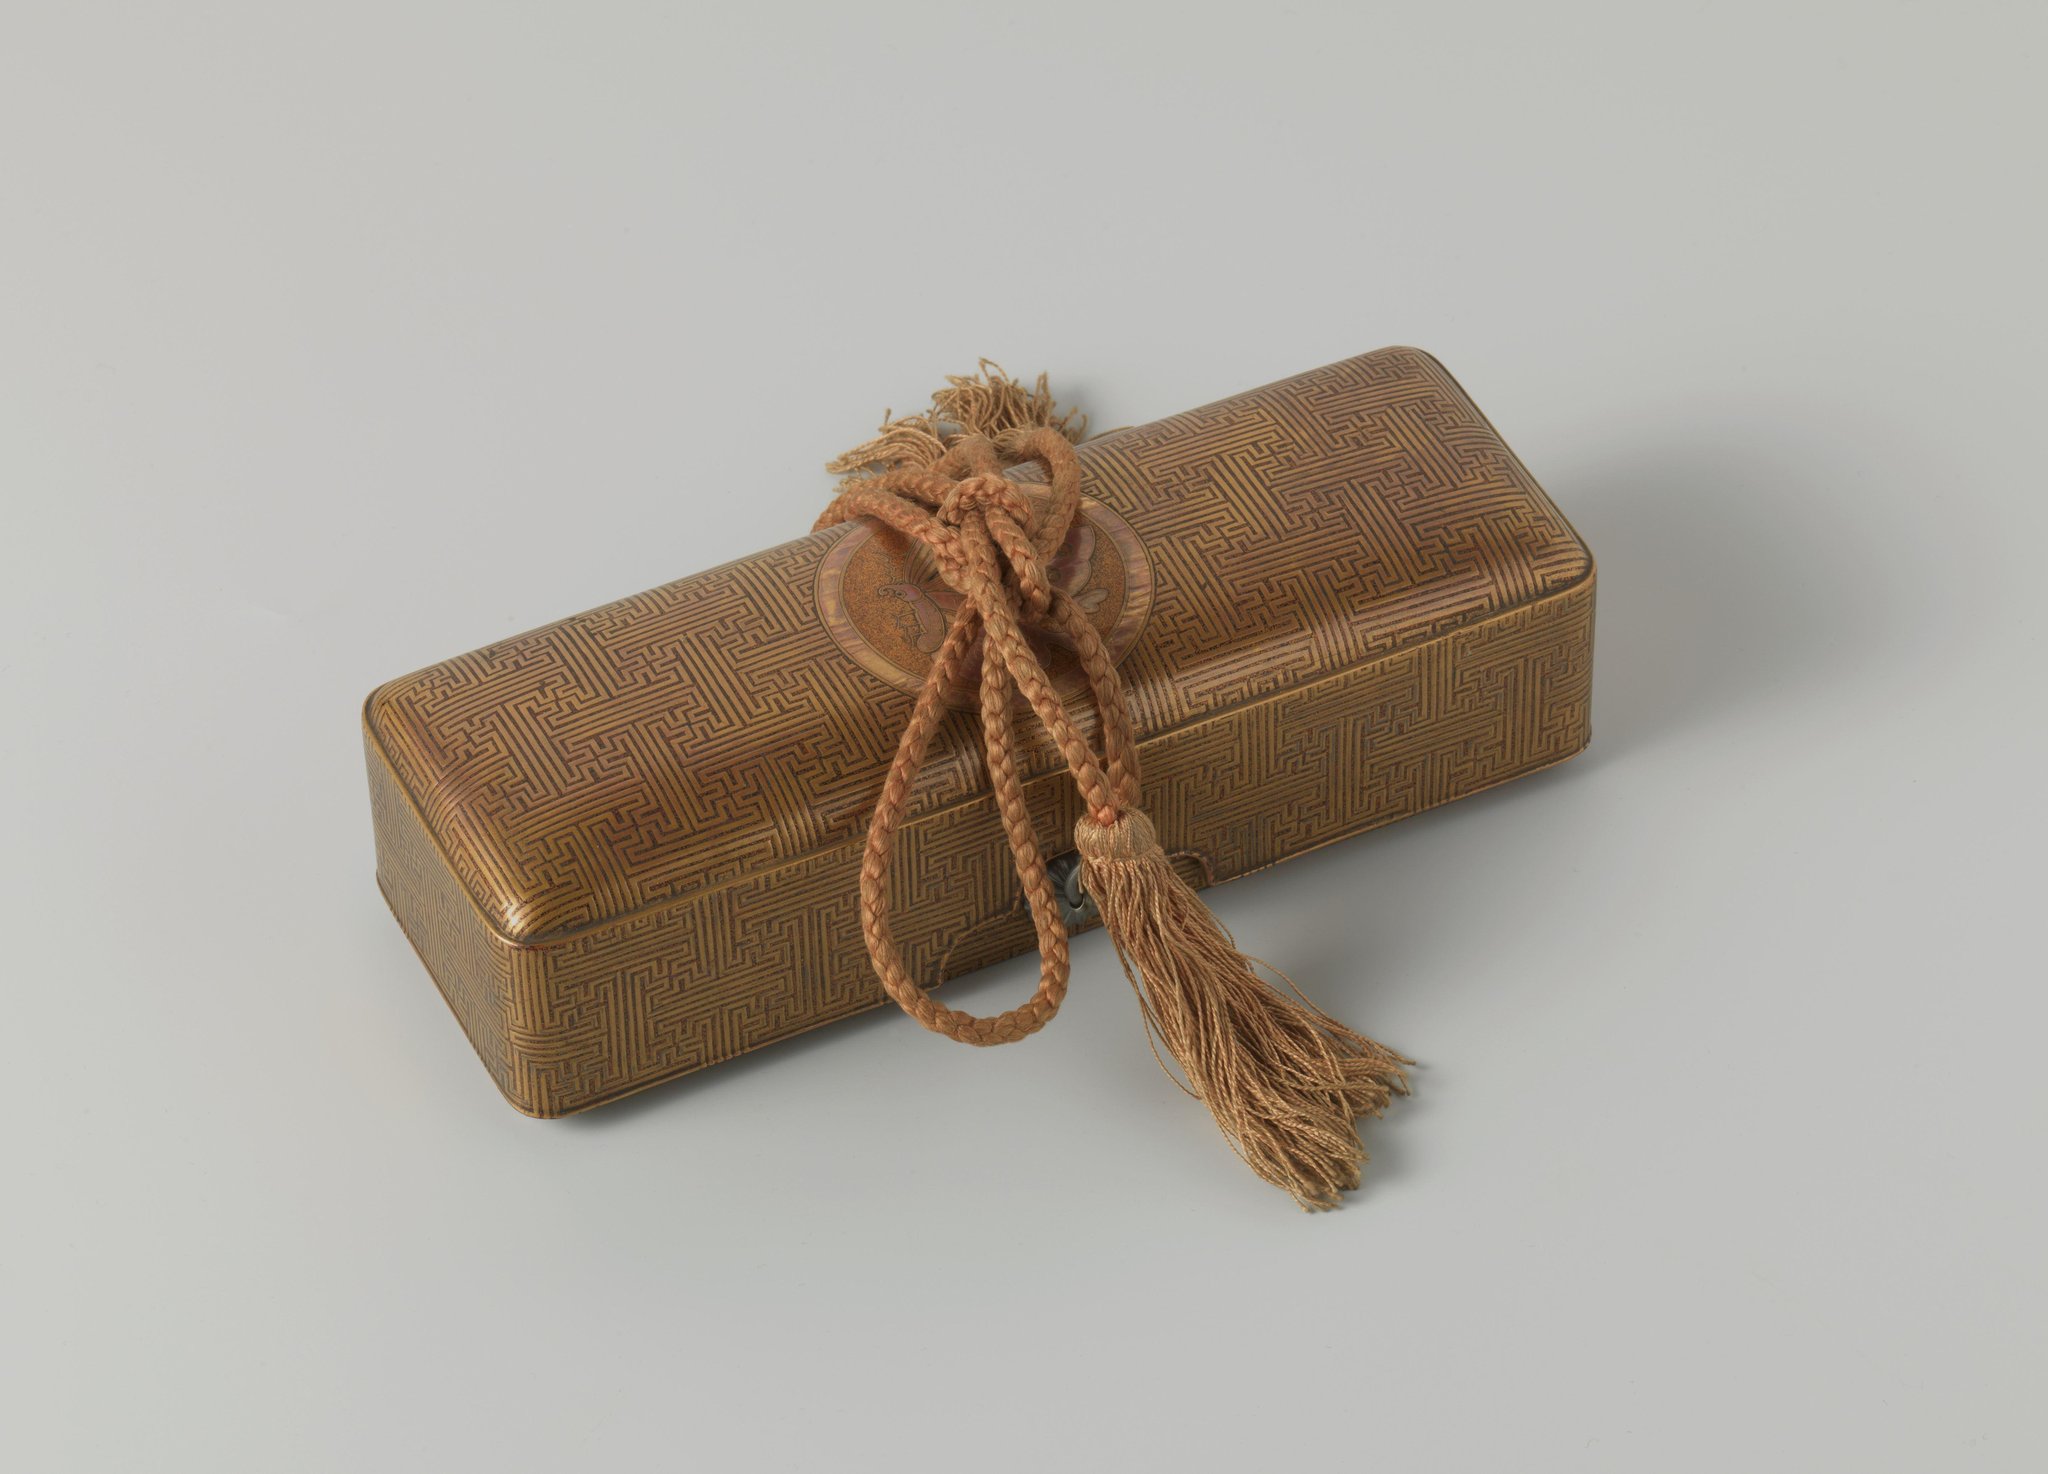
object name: box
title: Doos in Japanse goudlak, met koorden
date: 1880-1910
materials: wood